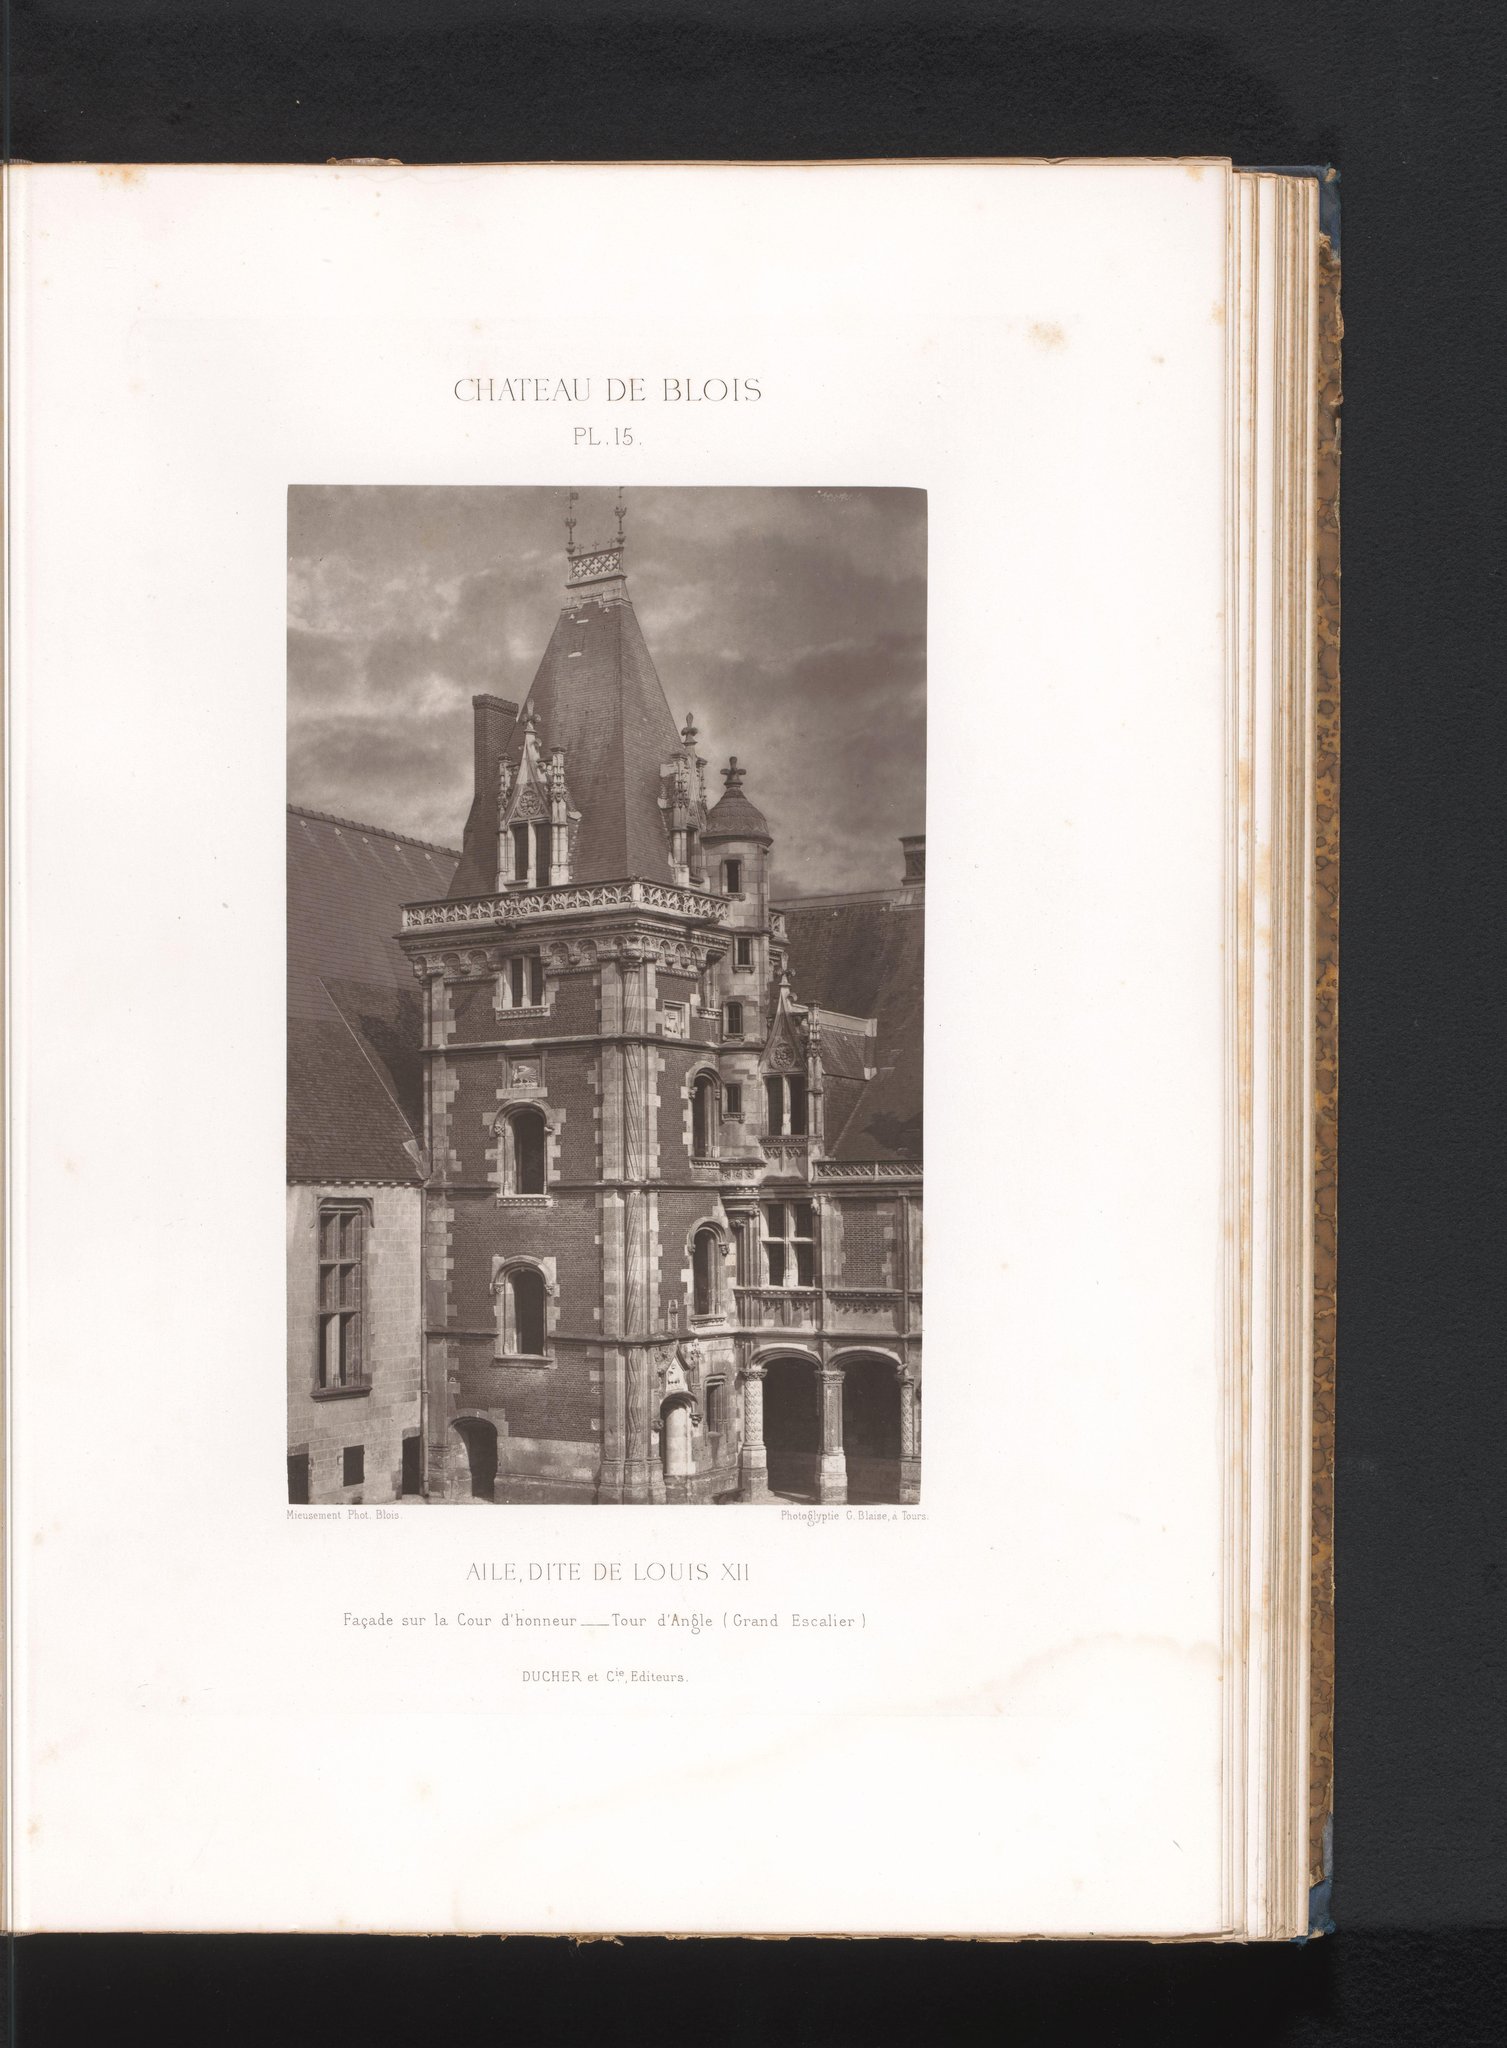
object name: page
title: Chateau de Blois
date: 1870-1875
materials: paper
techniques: woodburytype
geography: blois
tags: castle, tower (of house or building)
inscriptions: number: ‘PL. 15.’